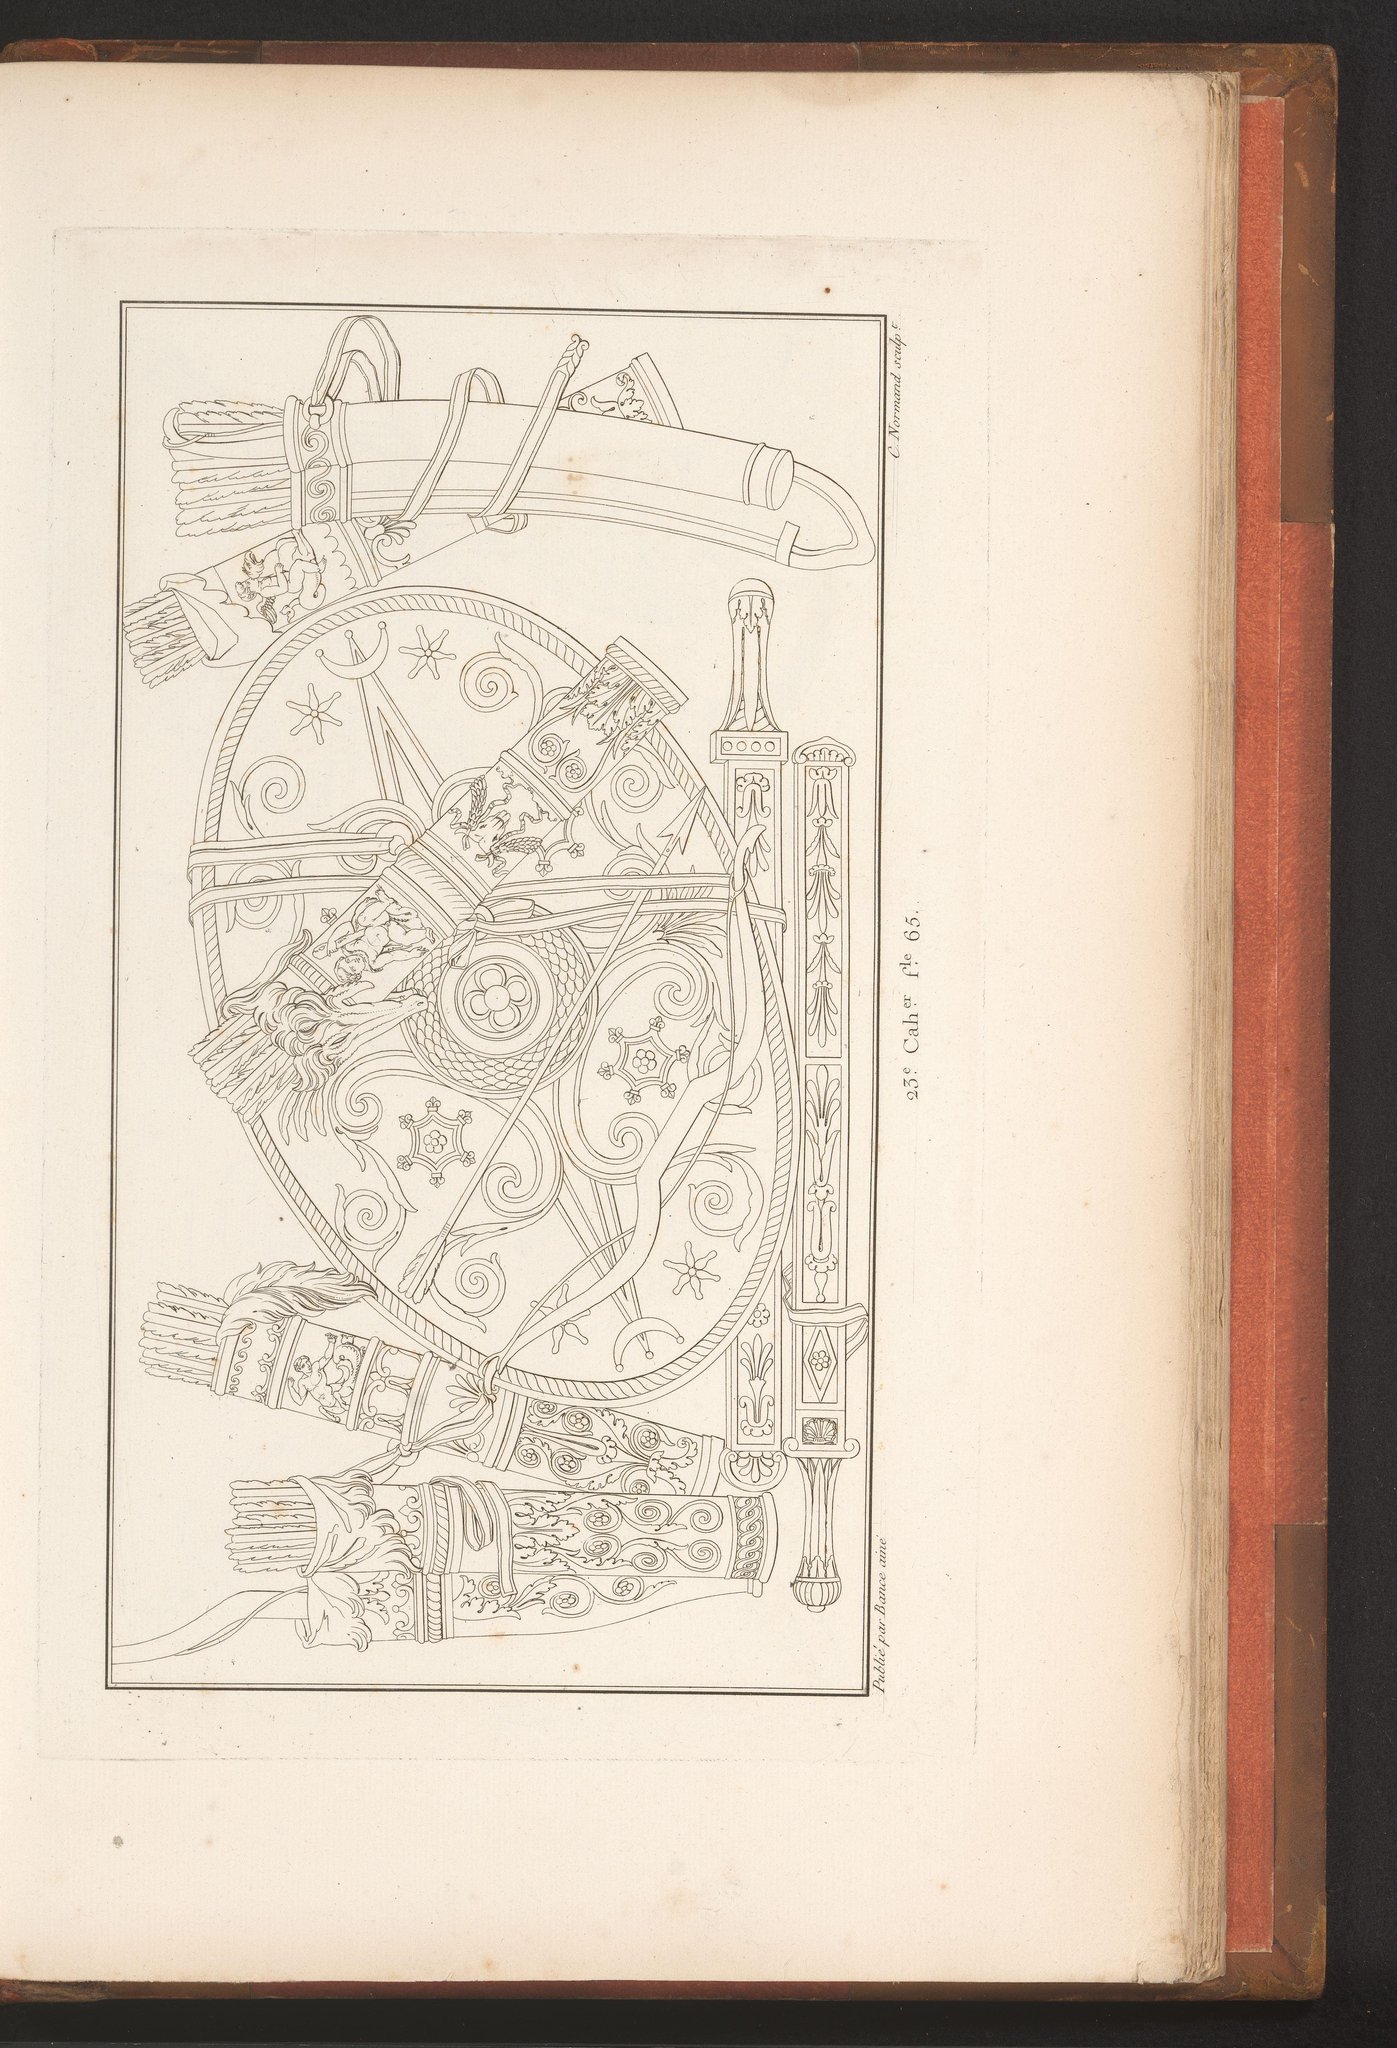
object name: ornament print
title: Wapentrofee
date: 1820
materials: paper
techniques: etching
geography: paris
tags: ornaments ~ art, 'tropaion', i.e. decorative ornament ~ weapons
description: Wapentrofee, ornament met wapens en wapenrusting, overgenomen van de Zuil van Trajanus. Onderdeel (23e. Cah.er f.le 65) van het prentalbum met twee series van in totaal 138 ornamentprenten door Beauvallet en Normand, 'Fragmens d'Ornemens dans le Style Antique'.